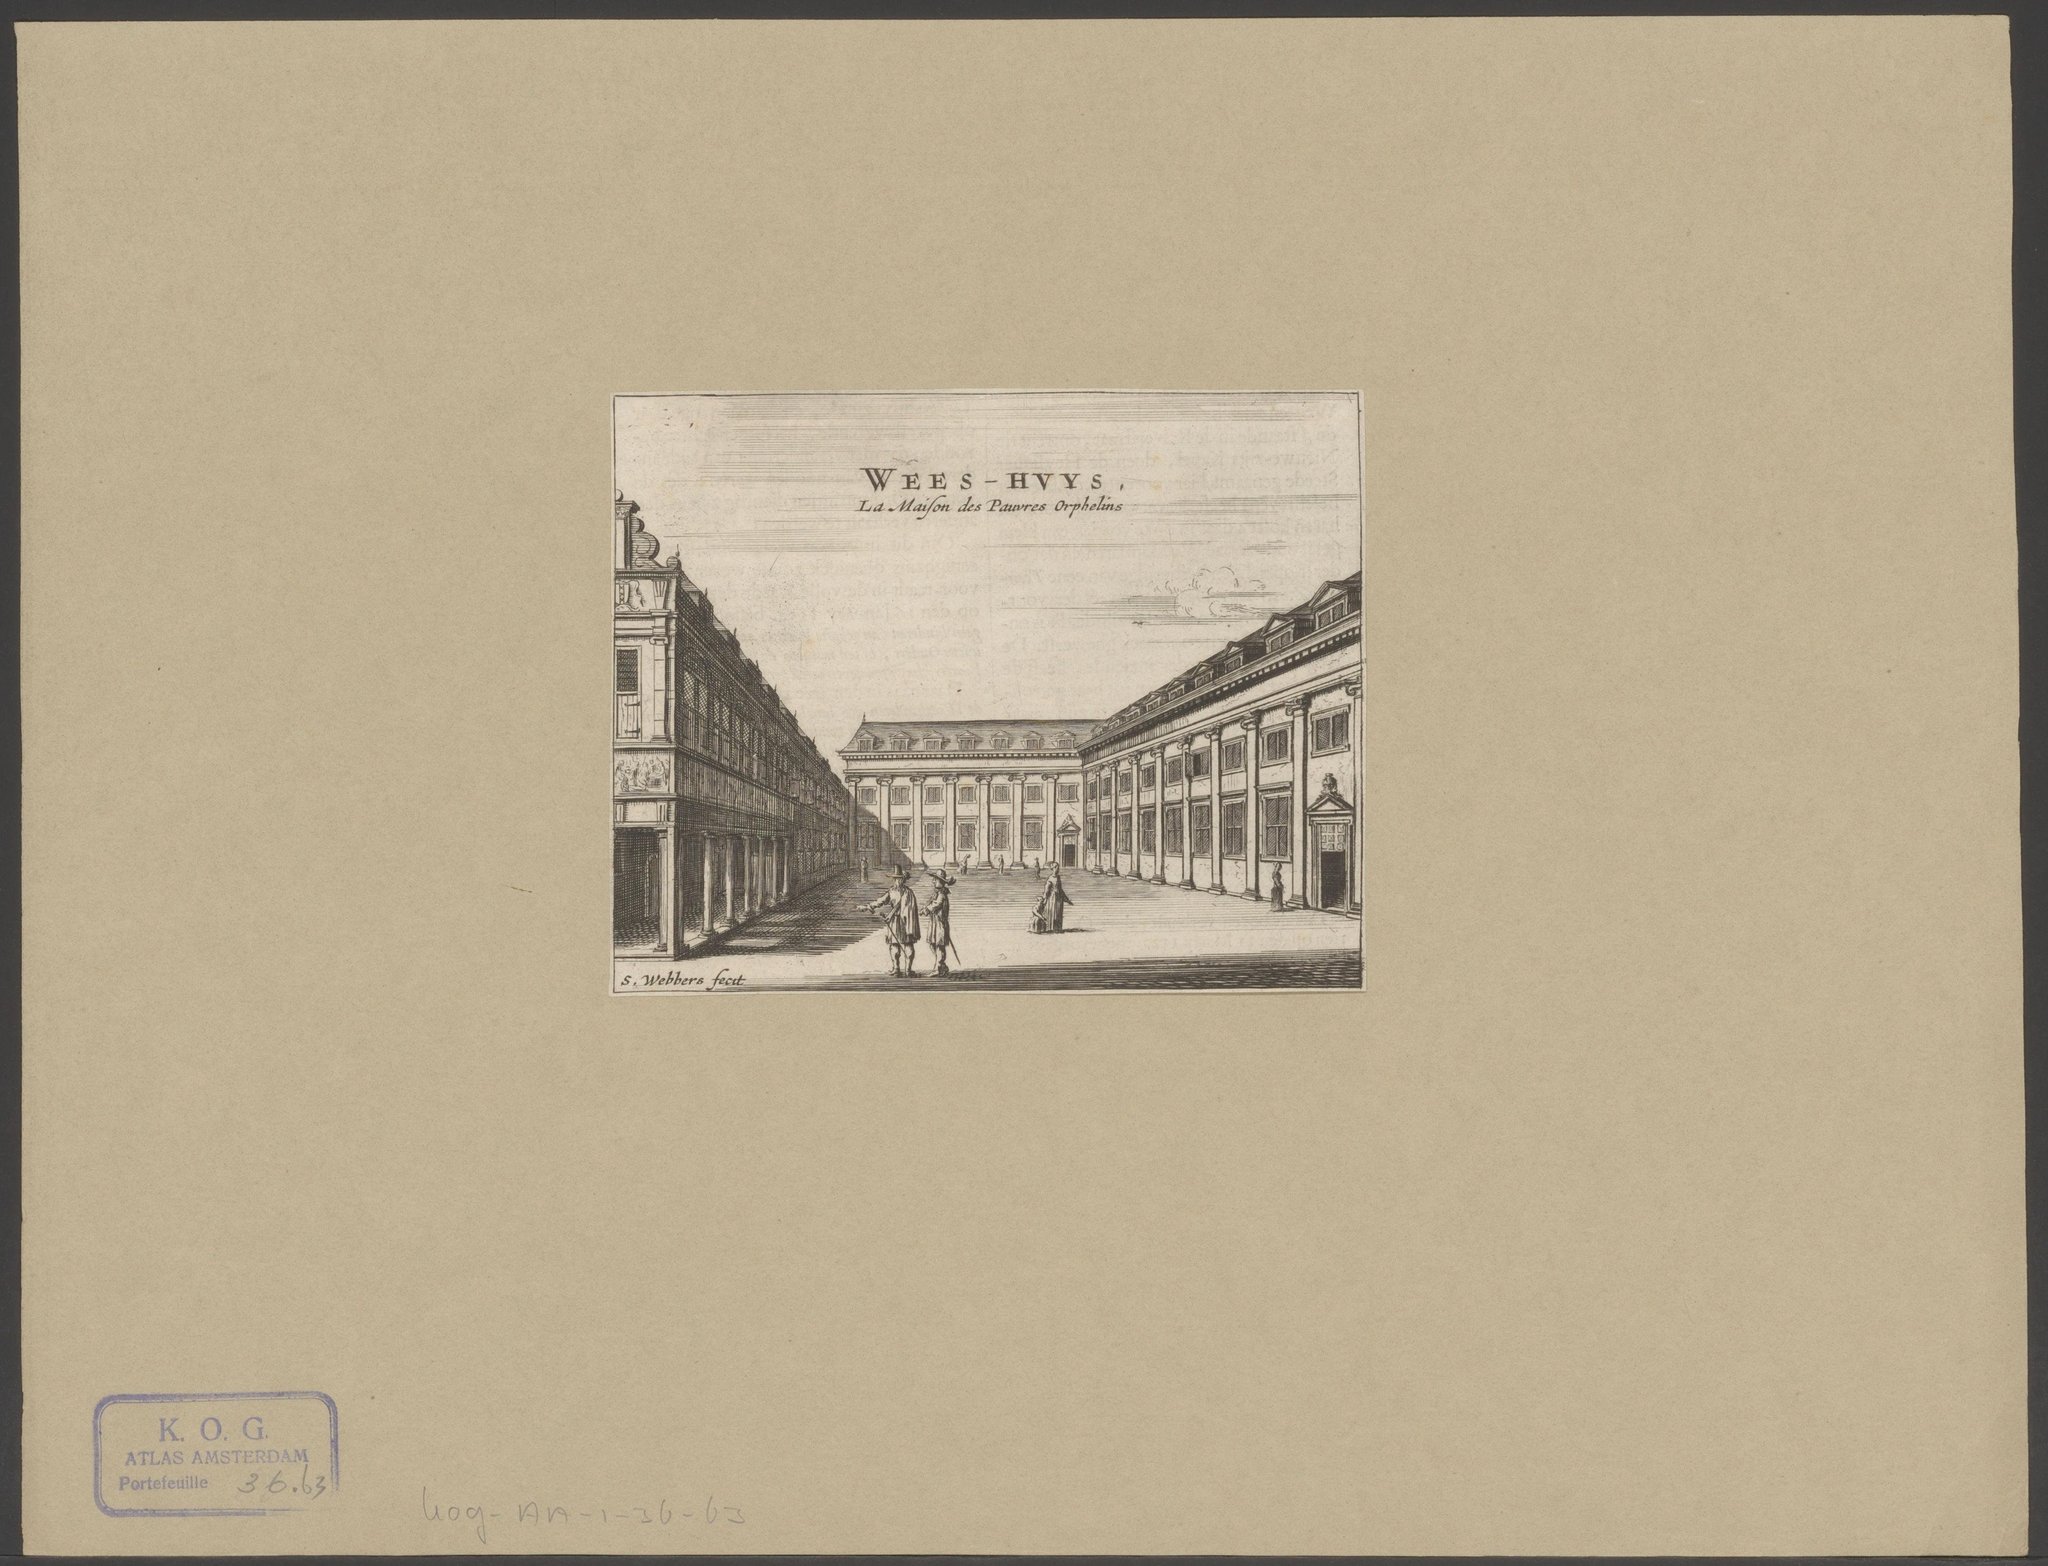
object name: print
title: Wees-huys / La Maison des Pauvres Orphelins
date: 1664-1665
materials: paper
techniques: engraving, etching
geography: amsterdam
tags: public welfare, courtyard, orphanage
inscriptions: collector's mark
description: Onderwerpsrubriek binnen de Atlas Amsterdam: Armwezen en liefdadige instellingen: I. Stadsinrichtingen: Burgerweeshuis.